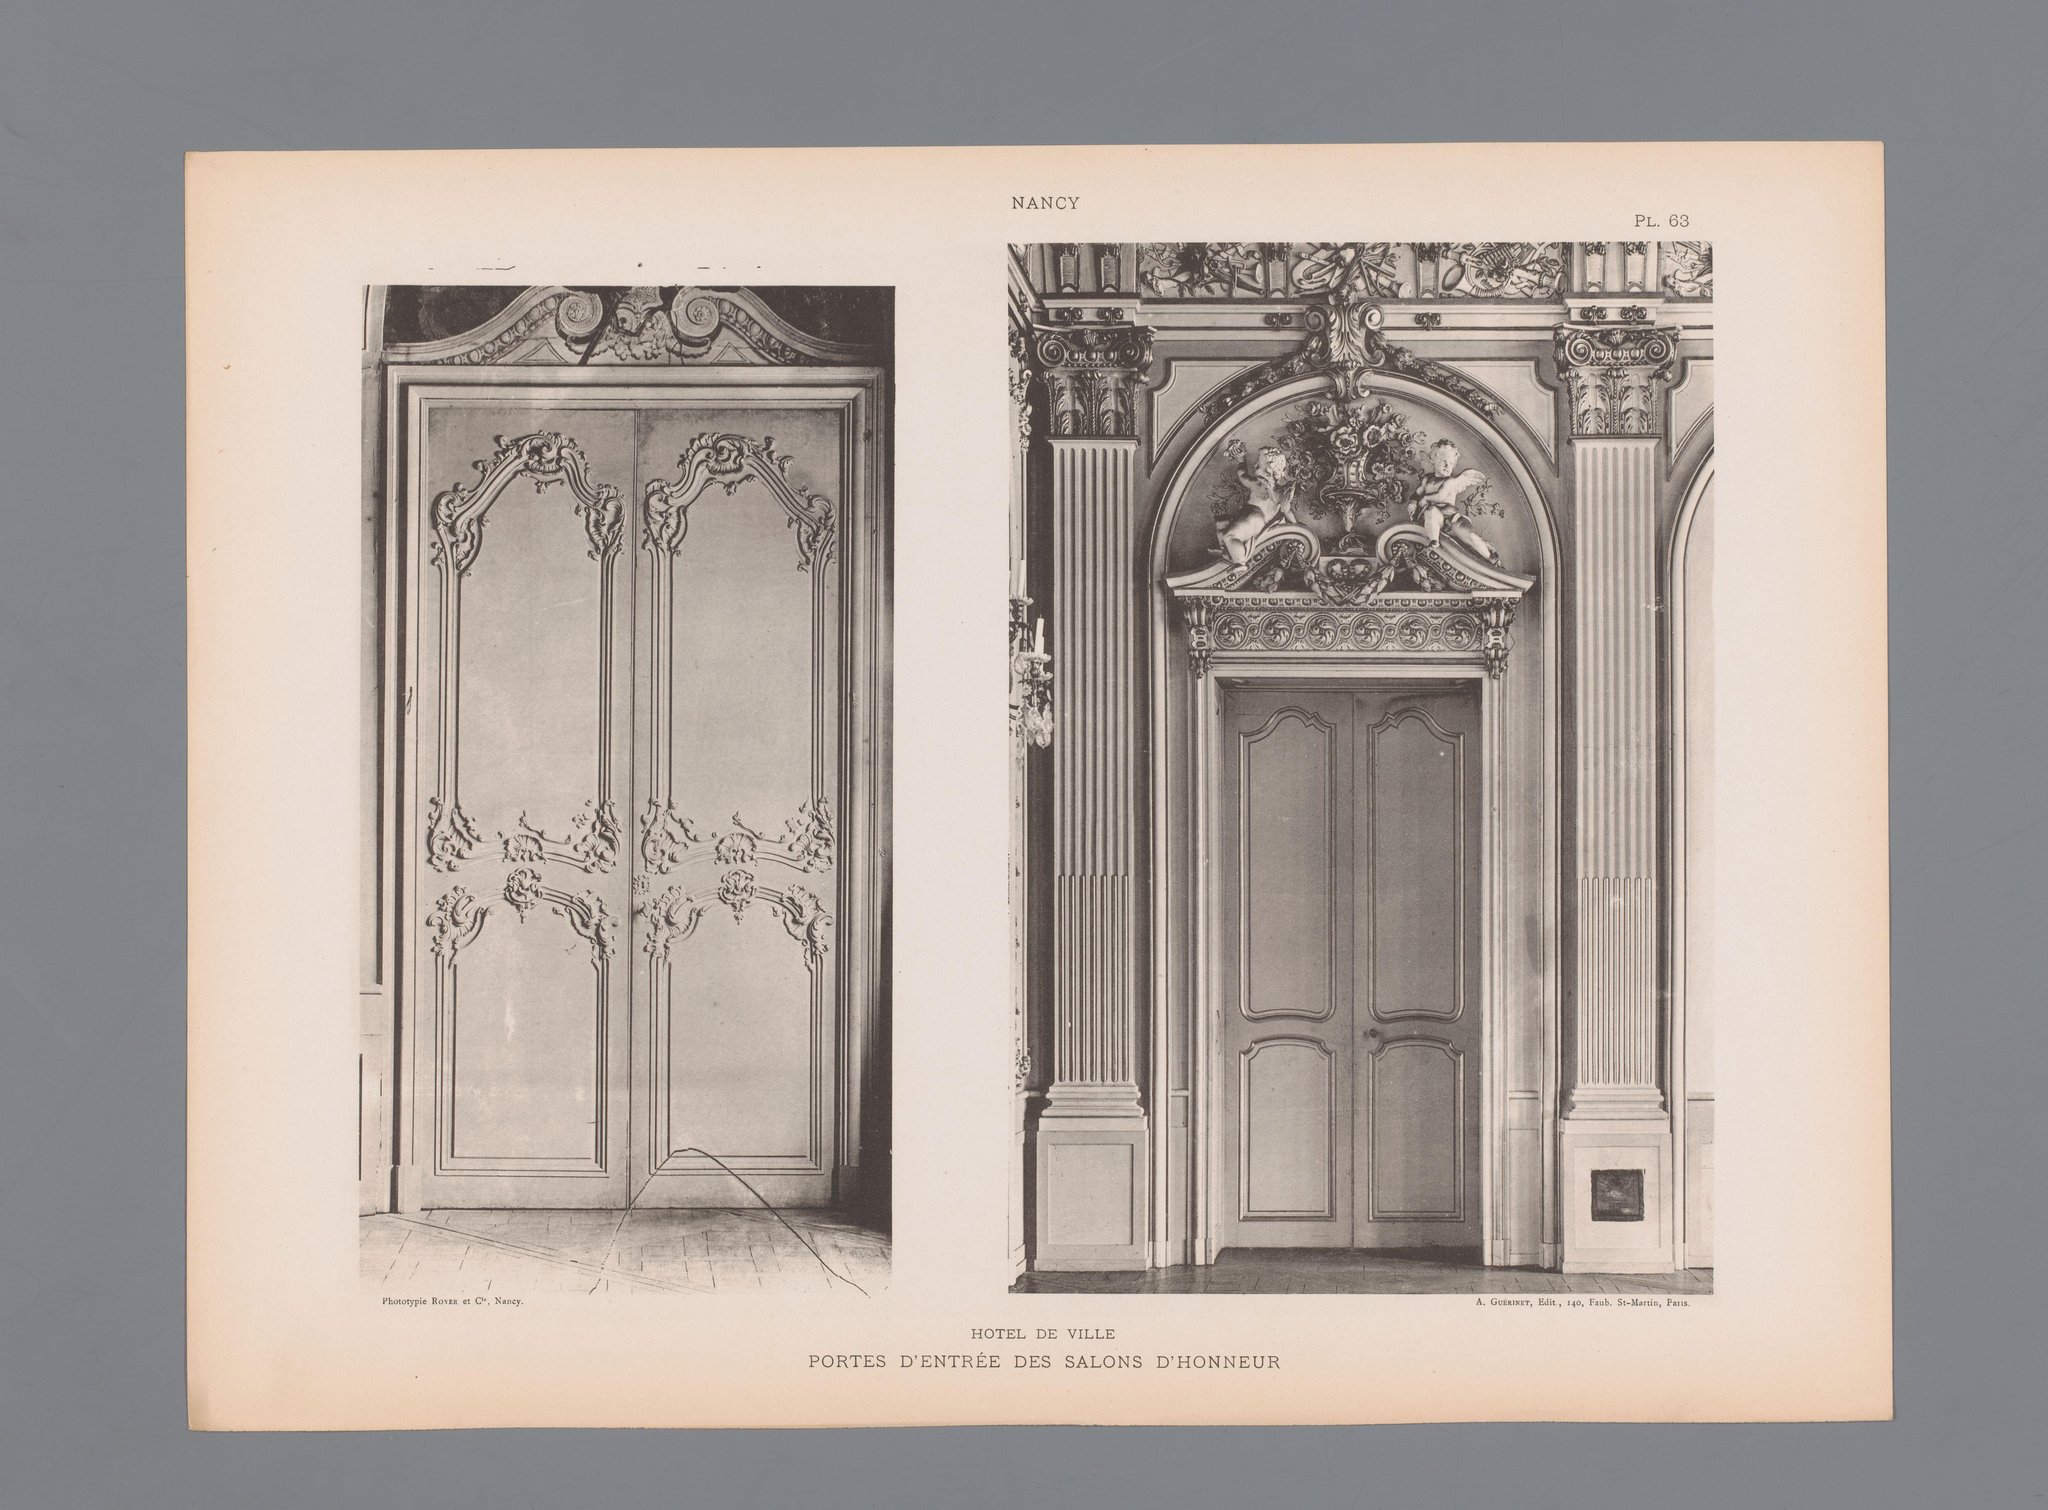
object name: photomechanical print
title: Twee versierde deuren in het stadhuis te Nancy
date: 1891-1896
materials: paper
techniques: photograph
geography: paris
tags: door, townhall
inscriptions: inscription: ‘Hotel de ville/ Portes d'entrée des salons d'honneur’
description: Deze prent maakt deel uit van een omslag met 103 prenten op 101 bladen en een titelblad.